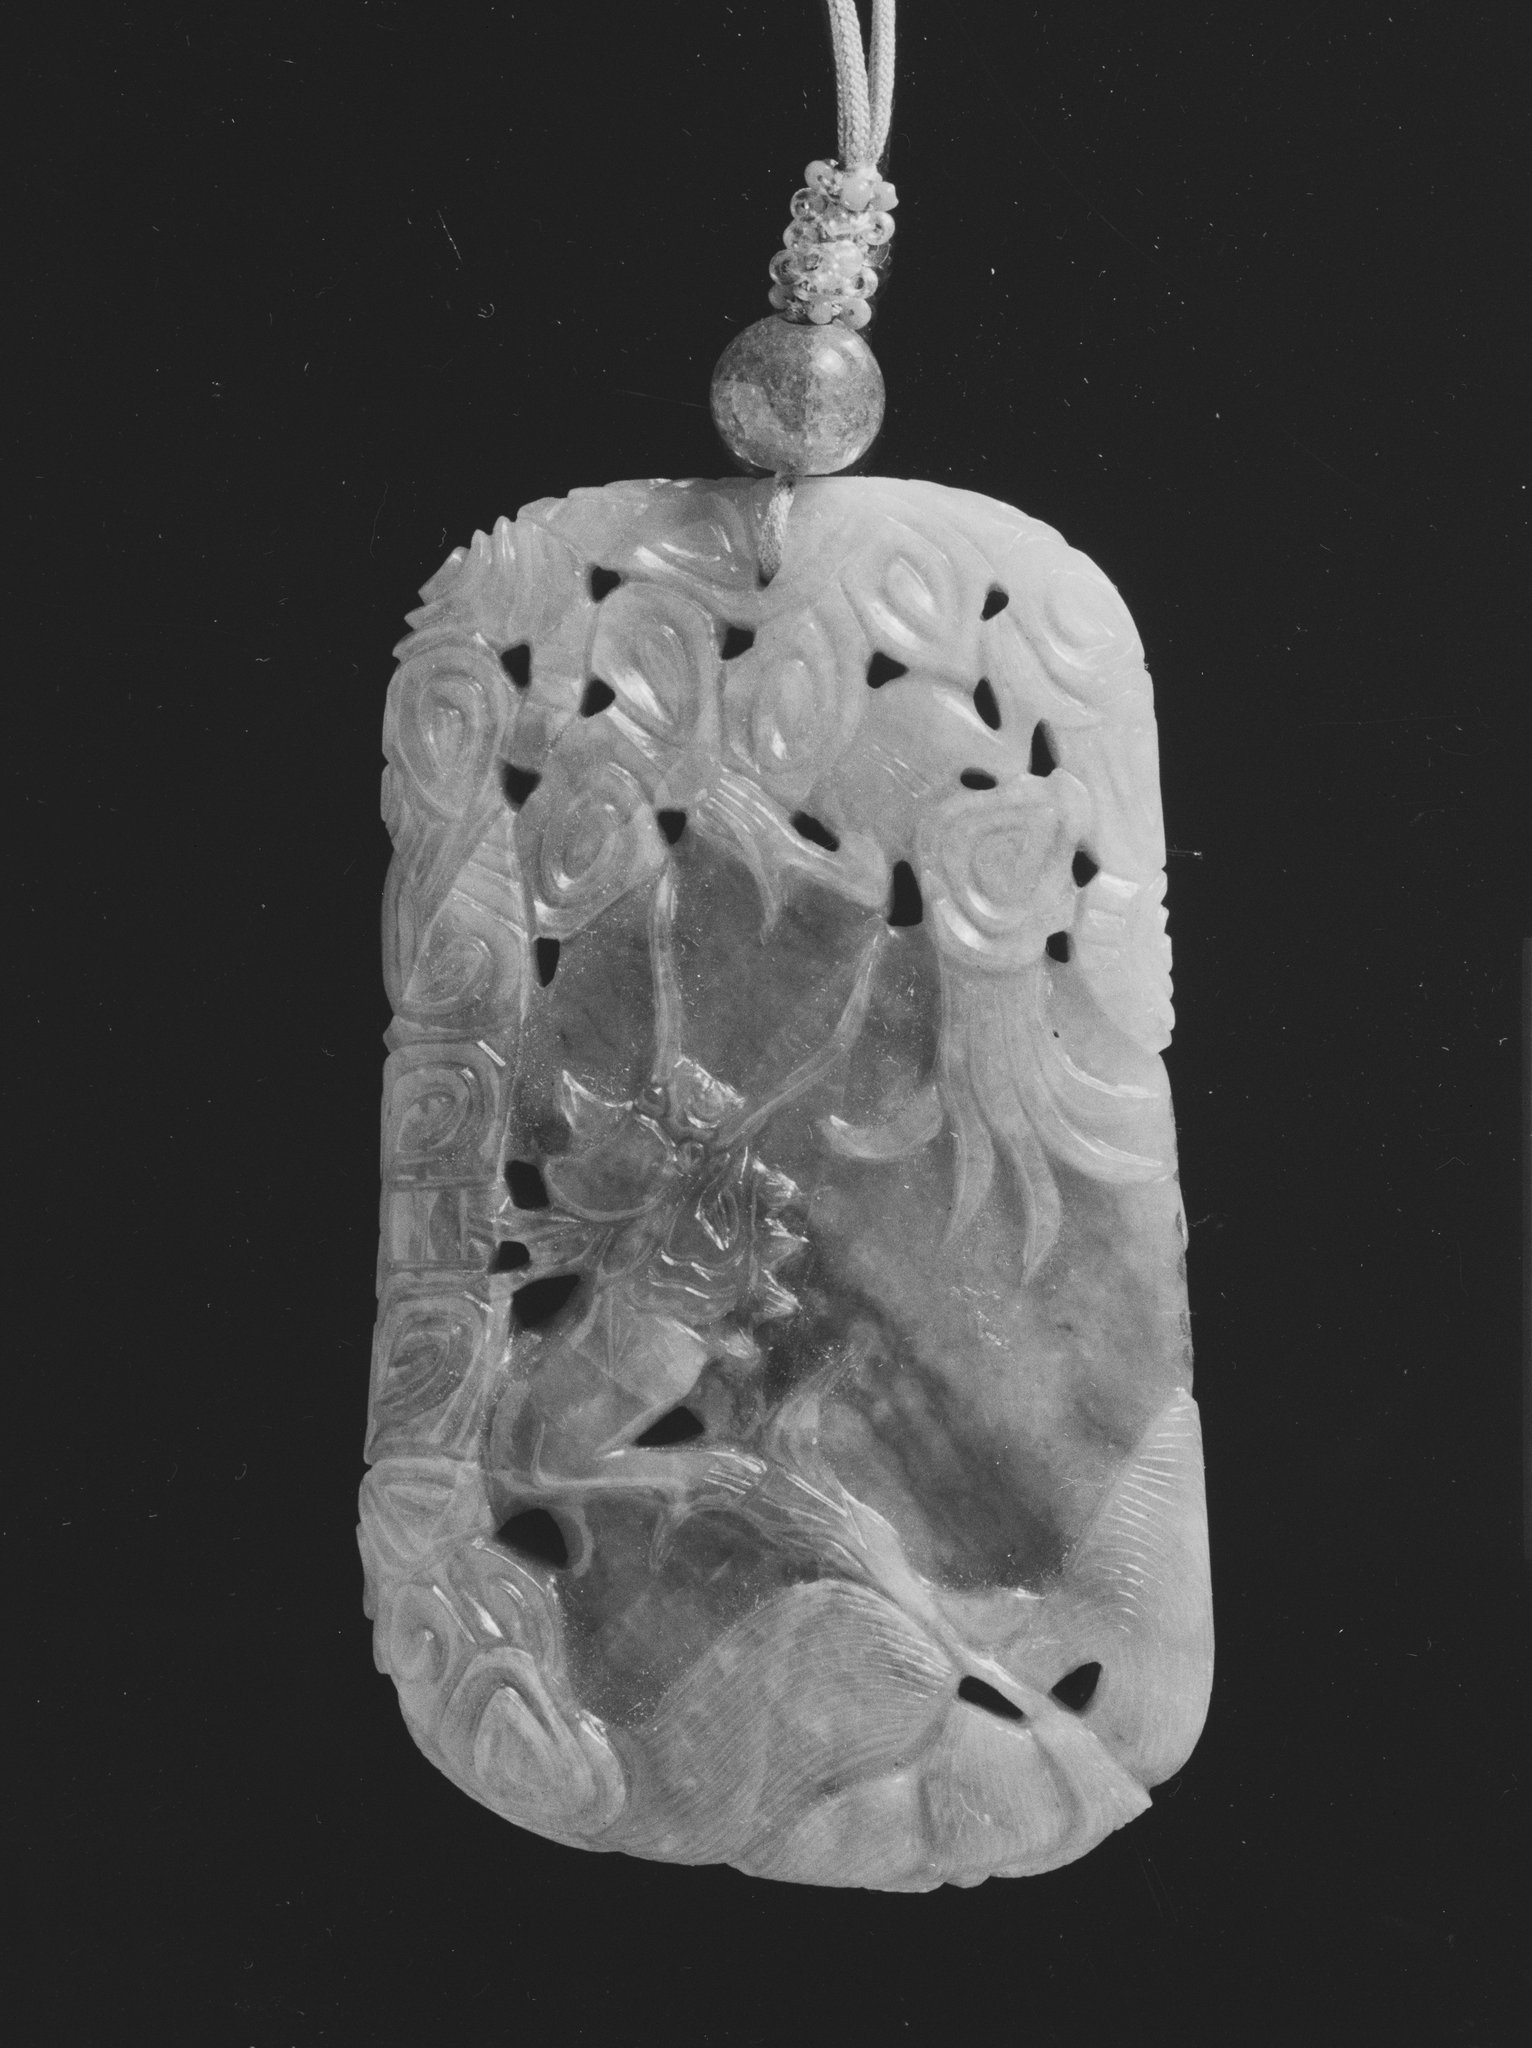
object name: pendant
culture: chinese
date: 1901-2000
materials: jade, pearl